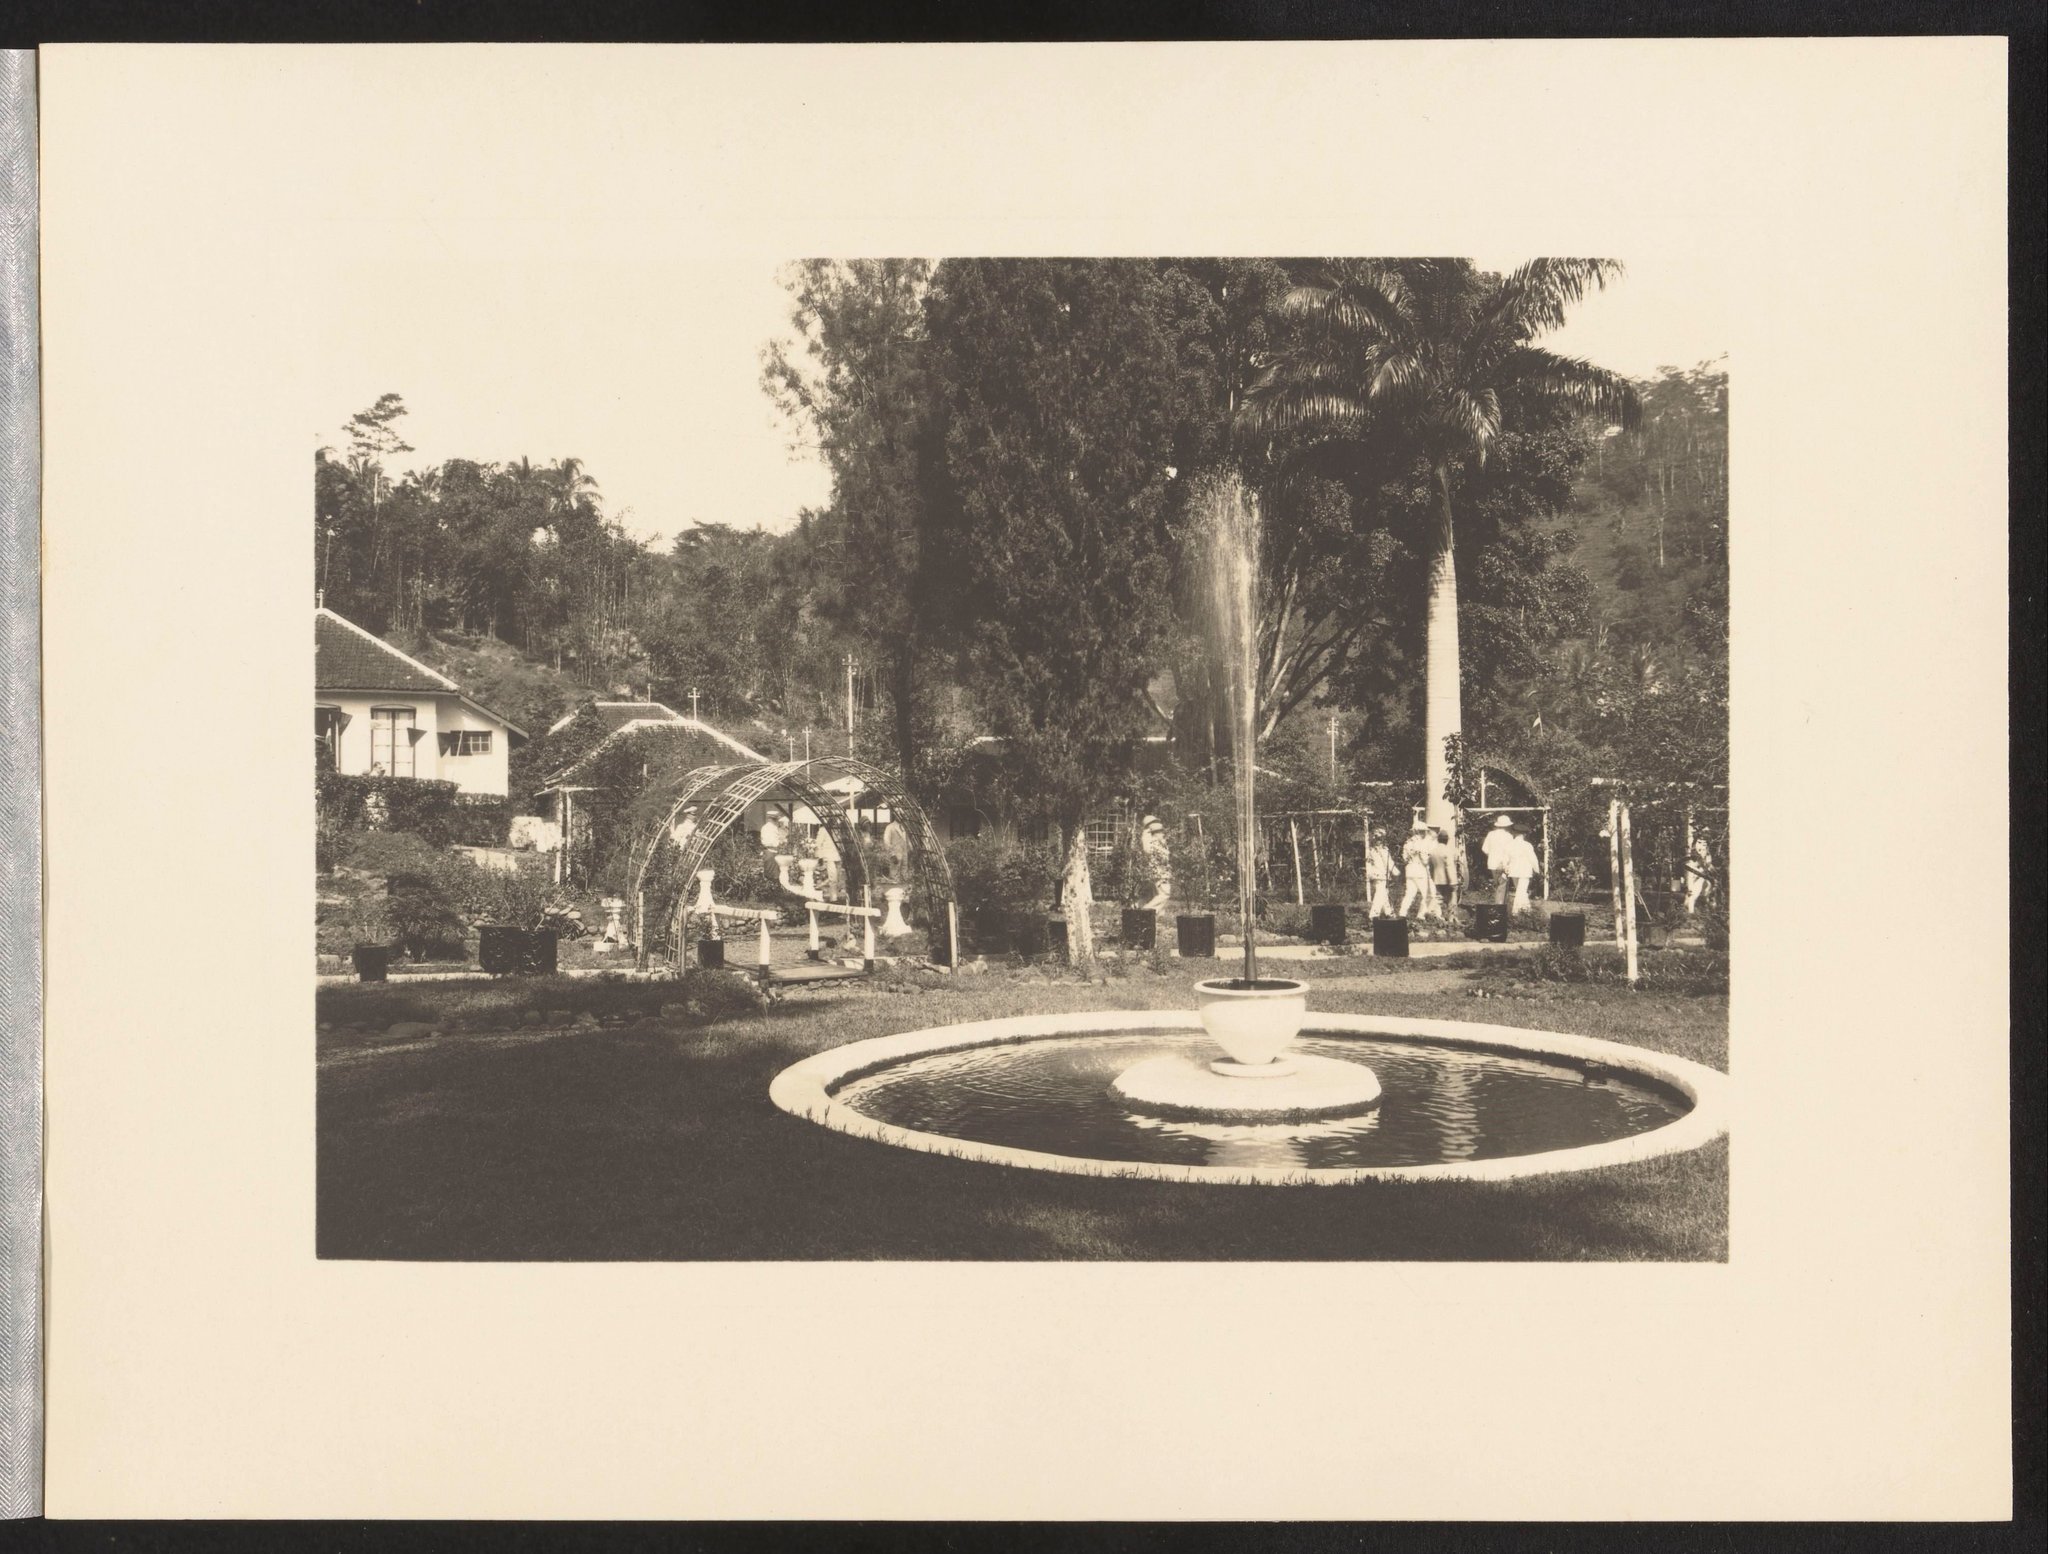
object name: photograph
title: Tuin van de leprozerie Pelantoengan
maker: otto hisgen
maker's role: fotograaf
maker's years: 1874-1944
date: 1905-1931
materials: photographic support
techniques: photography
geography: pelatoengan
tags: the hague, leprosarium, garden fountain, colonial government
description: De delegatie met gouverneur A.H. Neijs bij de tuin en fontein tijdens het bezoek aan de Semarang-leprozerie in Pelantoengan in mei 1931. Losse foto in de map met herinneringsfoto's van het bezoek aangeboden aan gouverneur A.H. Neijs.